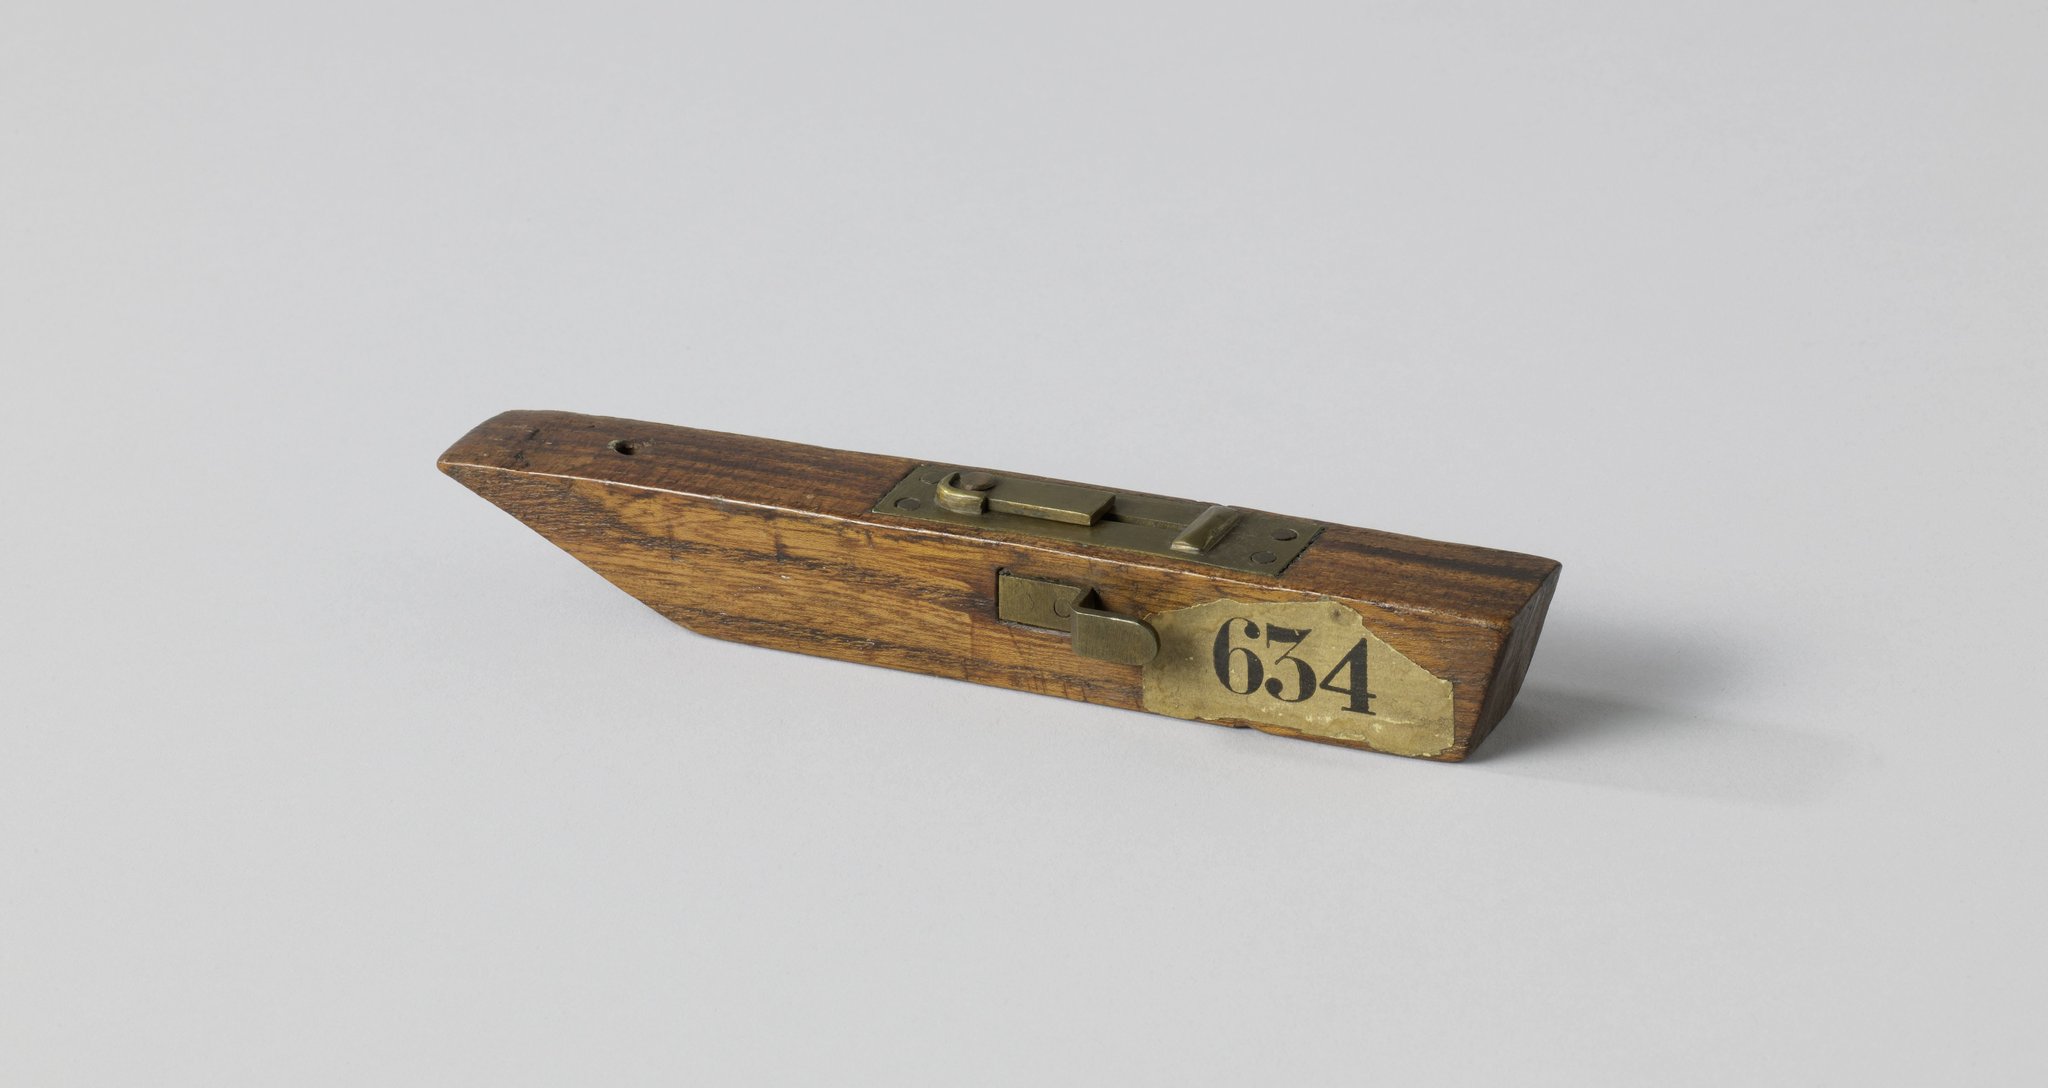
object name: demonstration model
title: Model of an Anchor Release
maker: Anonymous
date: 1826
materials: brass, wood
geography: netherlands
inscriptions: label: ‘634’ former inventory label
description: De werking is niet helemaal duidelijk. Obreen specifieert geen maker bij dit catalogusnummer. In de archieven wordt Van Houten's model (zie vorig nummer) samen met een model van Burton (foute spelling van Brunton); op het model van de Vergelijking zijn twee kraanbalken met ankerval volgens Brunton gemonteerd.